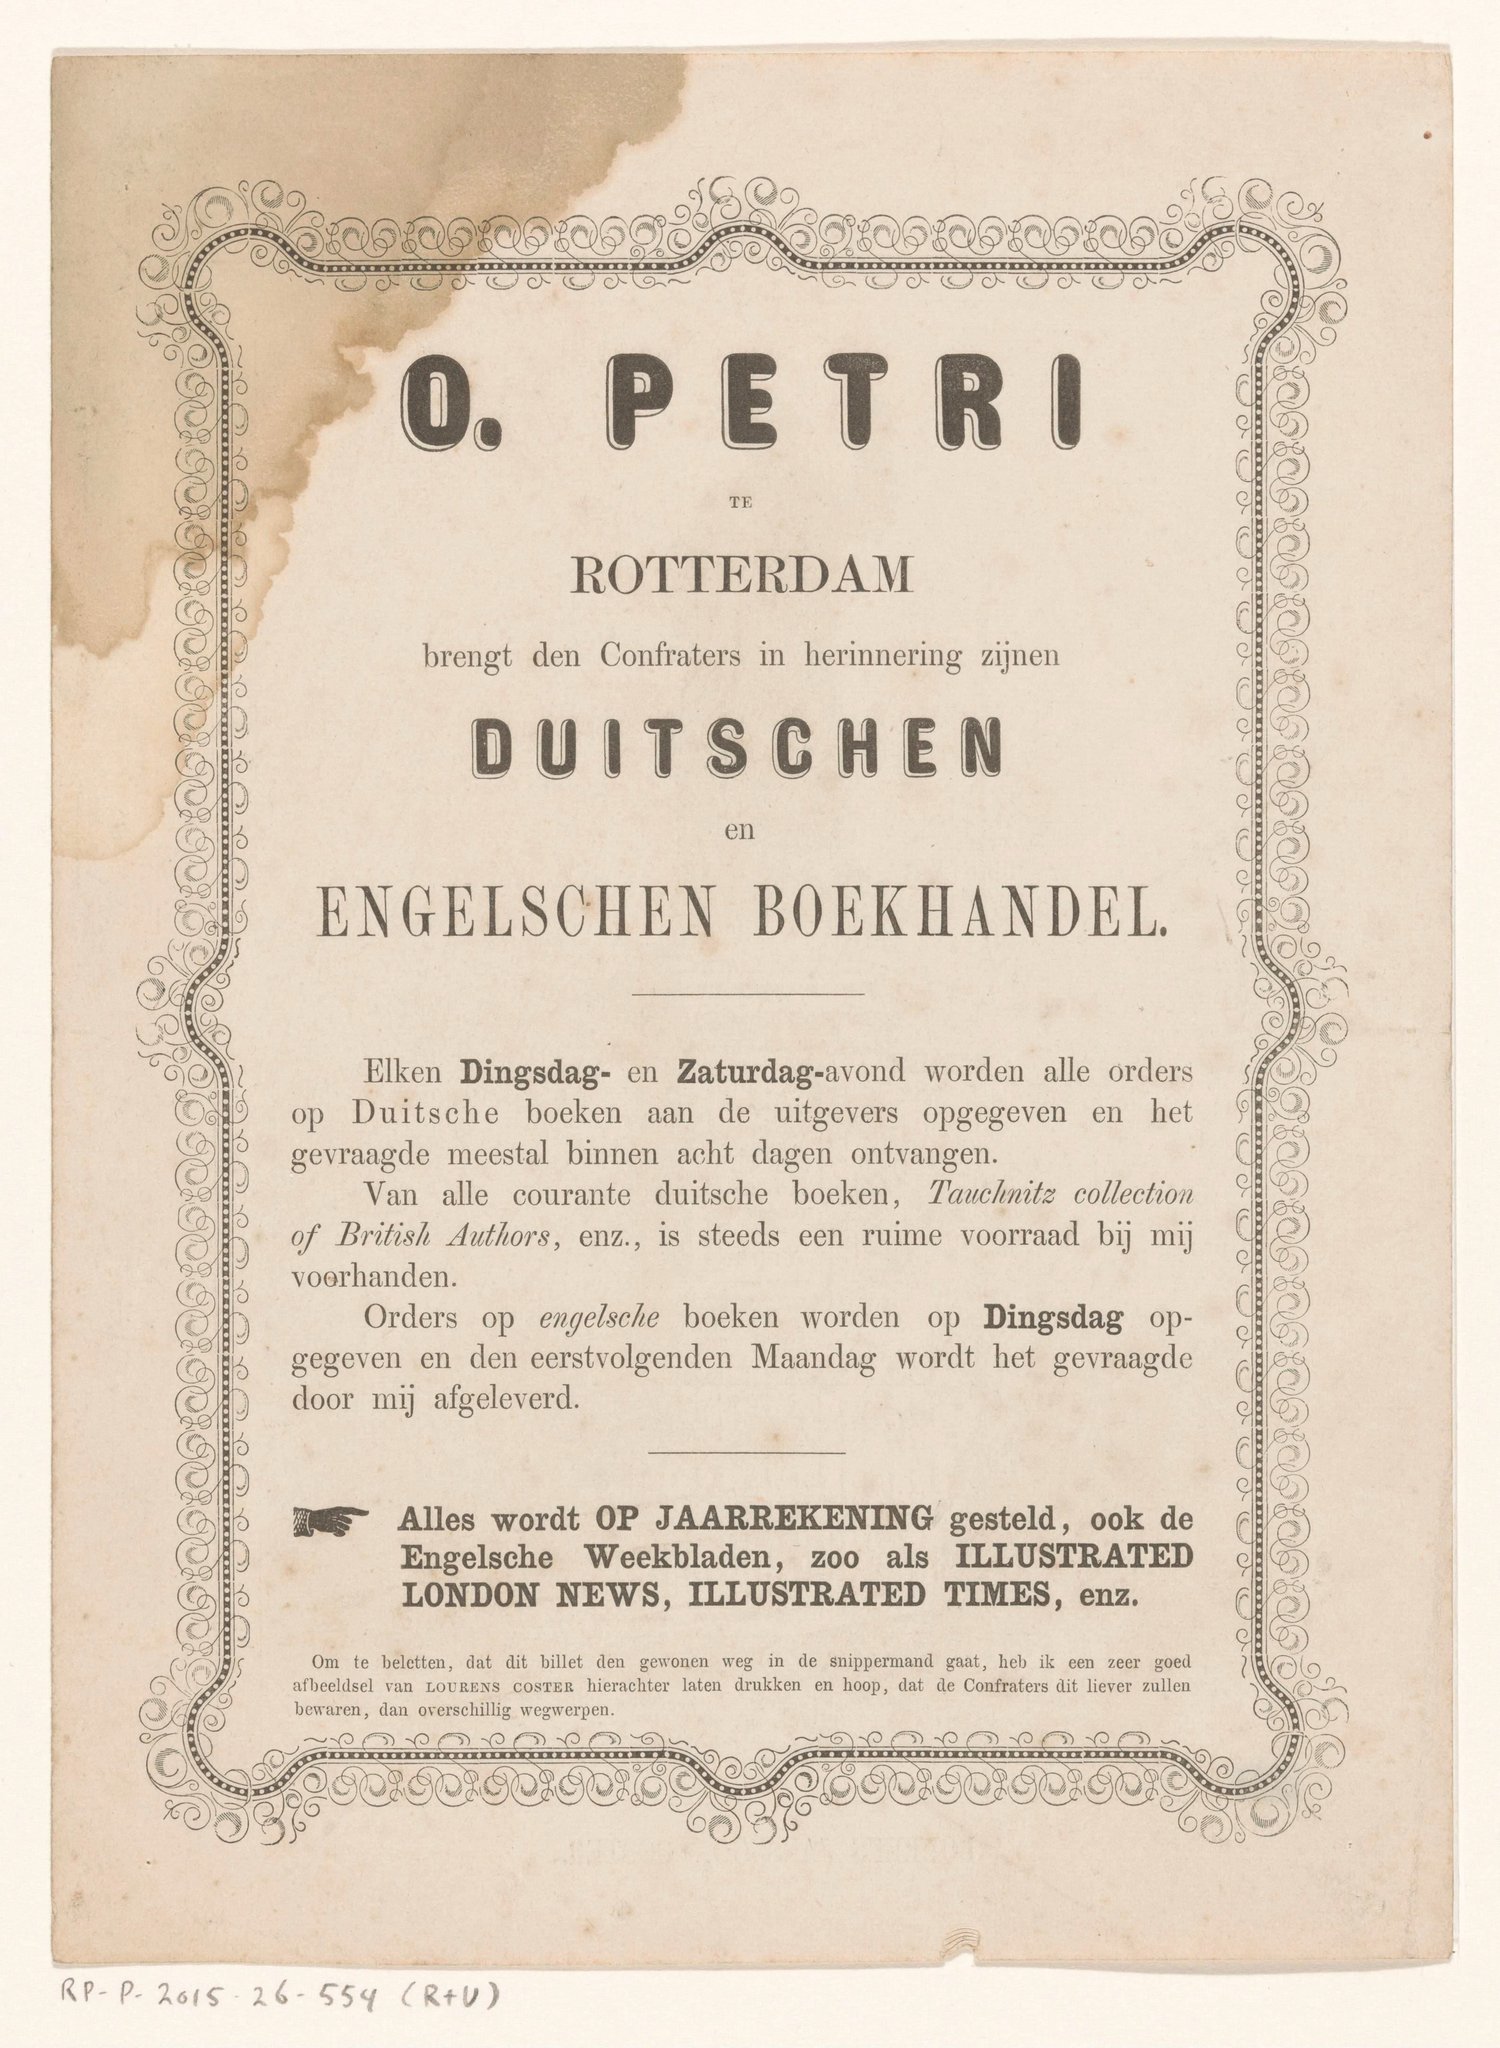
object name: reclamebiljet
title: Reclamebiljet van boekhandelaar Otto Petri te Rotterdam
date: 1856-1882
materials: paper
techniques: letterpress printing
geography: rotterdam